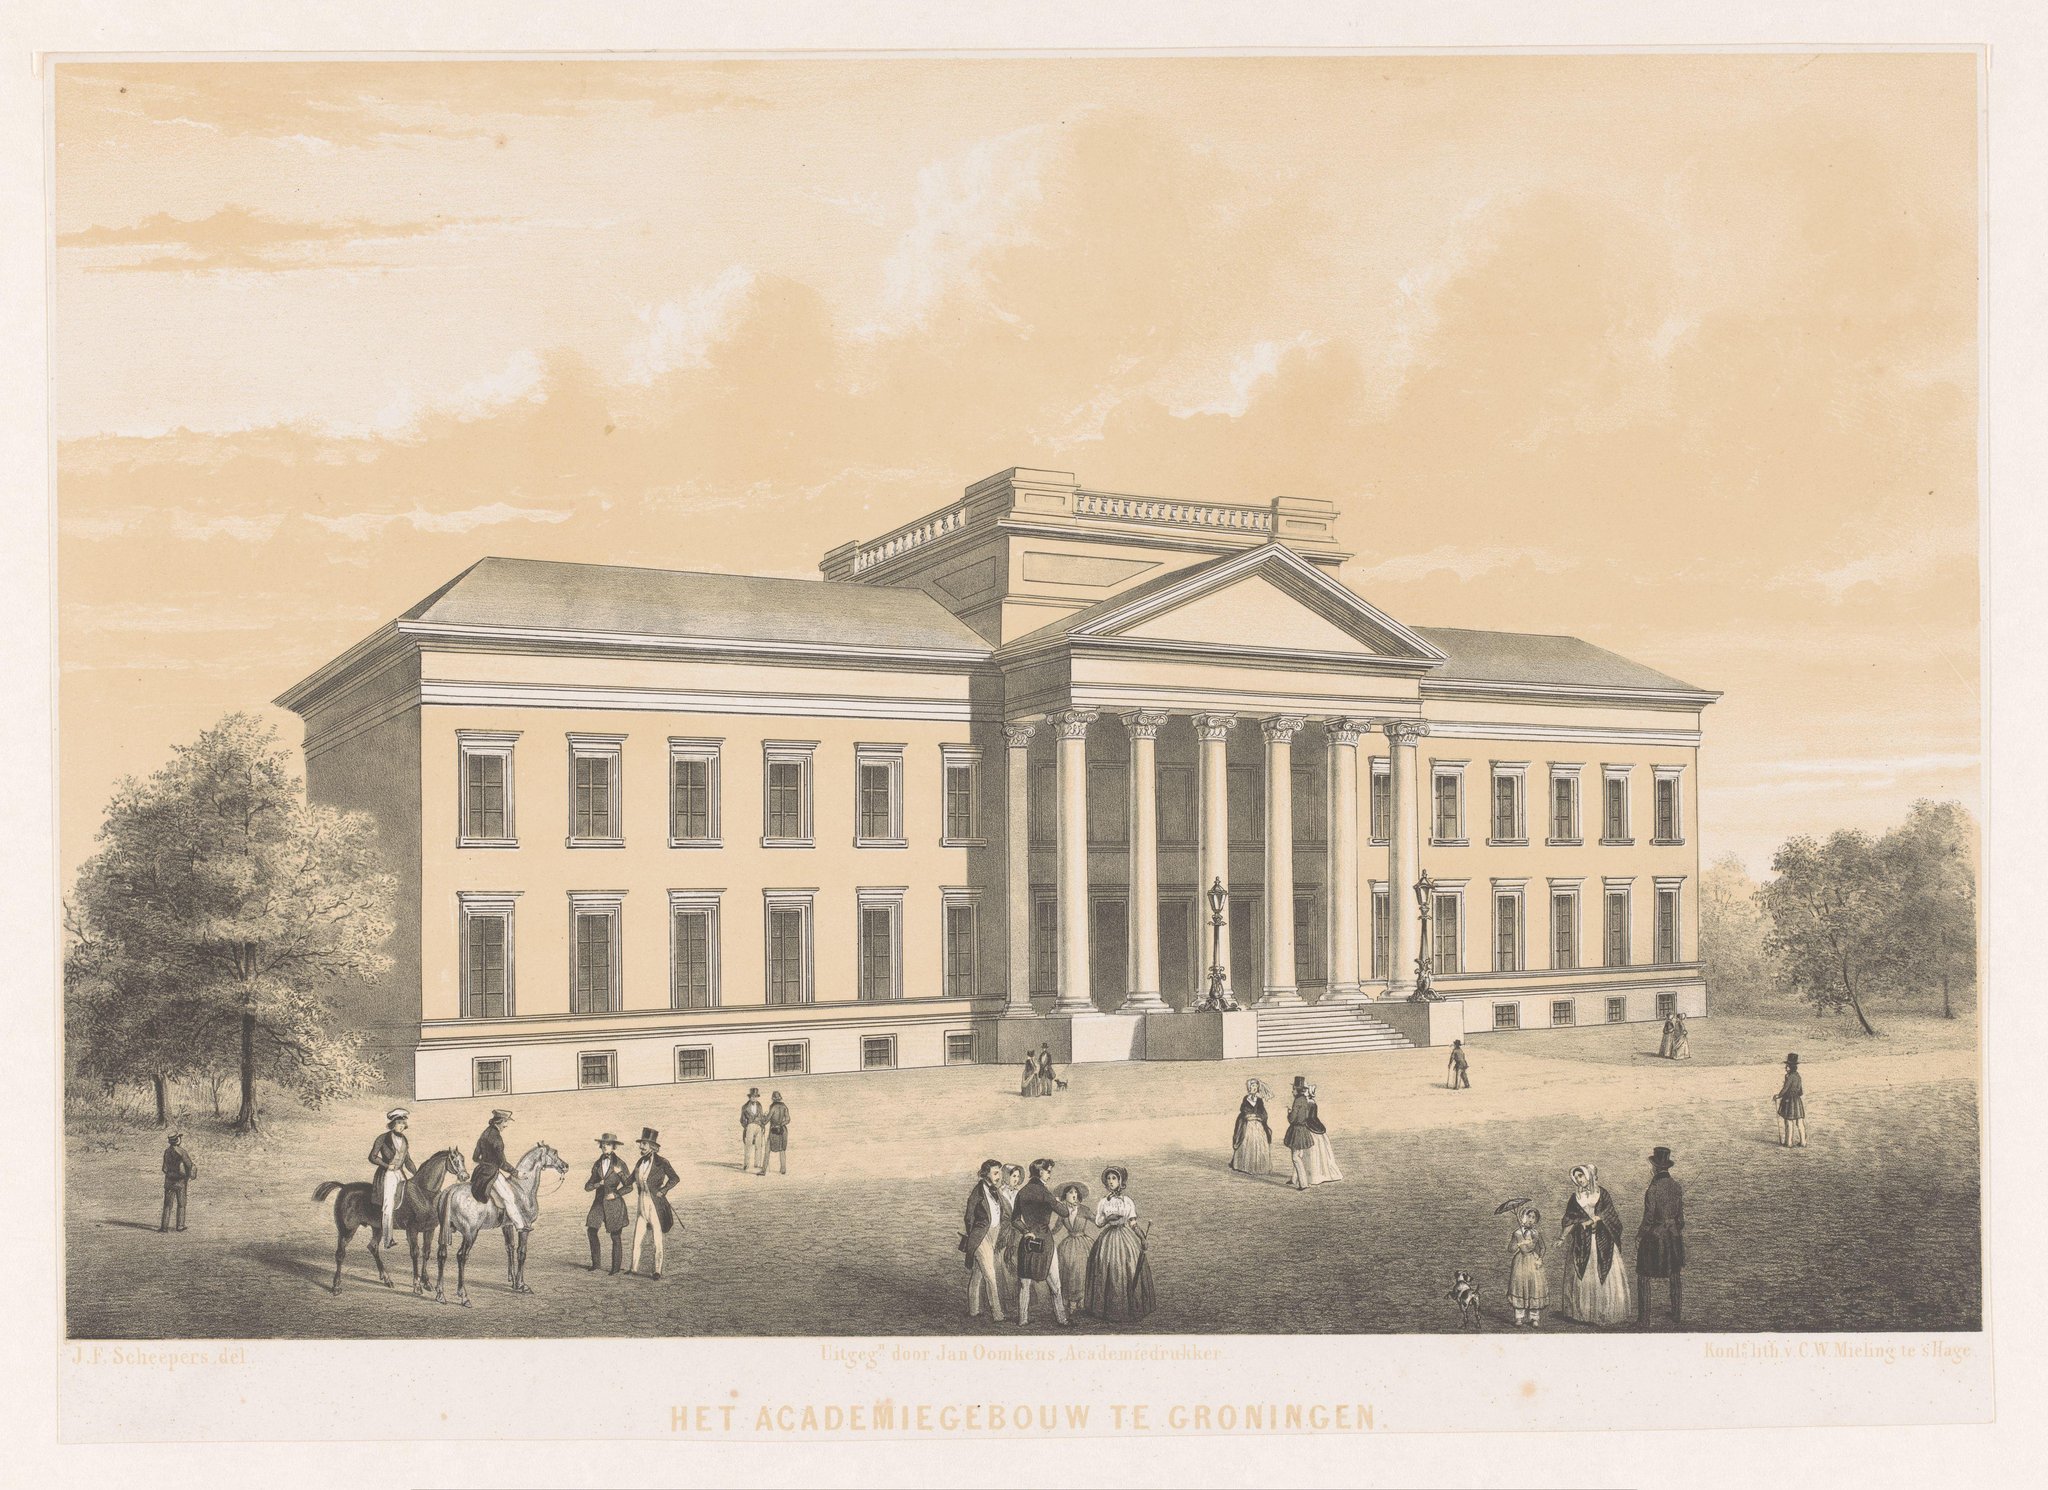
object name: print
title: Academiegebouw te Groningen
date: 1850-1865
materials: paper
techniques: tone lithography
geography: groningen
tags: university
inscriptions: collector's mark: Lugt 2228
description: Het (tweede) Academiegebouw te Groningen, gebouwd in 1850. Op het plein voor het gebouw lopen figuren en twee mannen te paard.